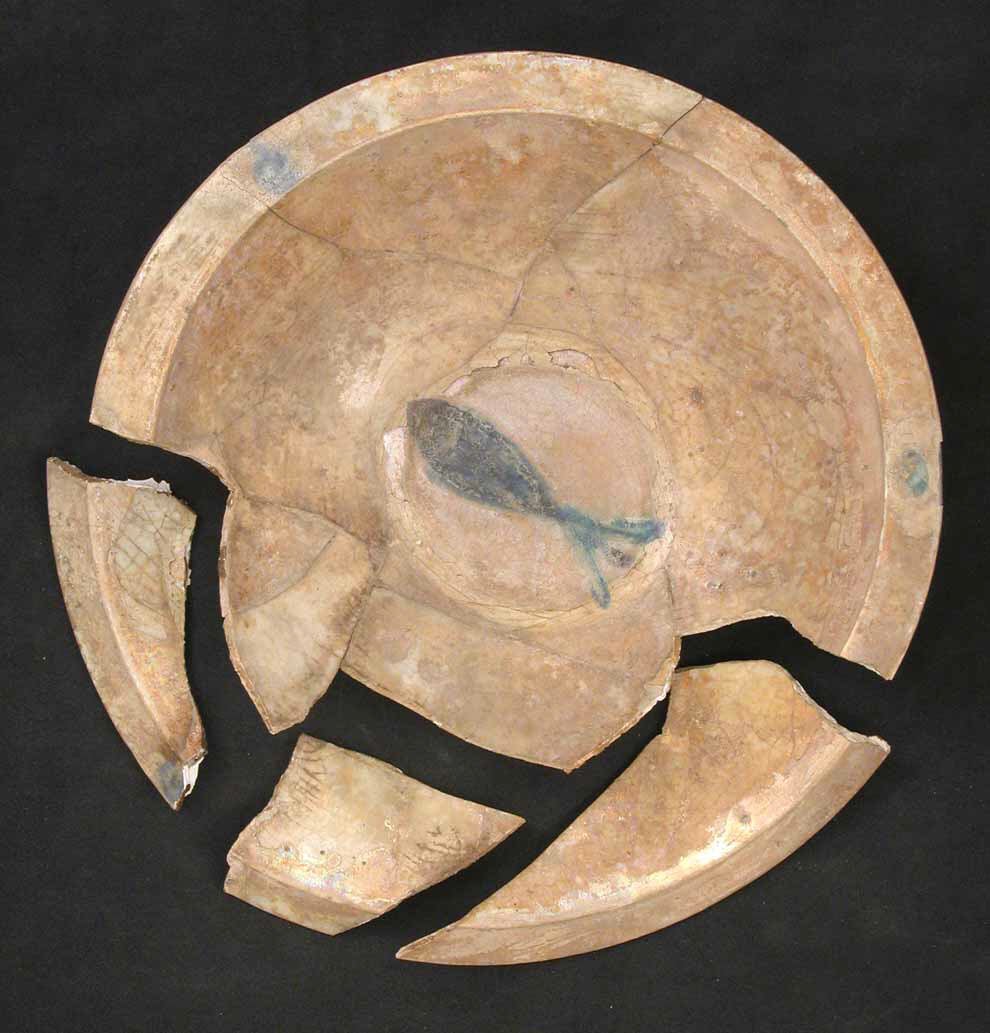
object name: bowl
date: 1101-1200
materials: earthenware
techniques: glazing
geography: syria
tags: fish